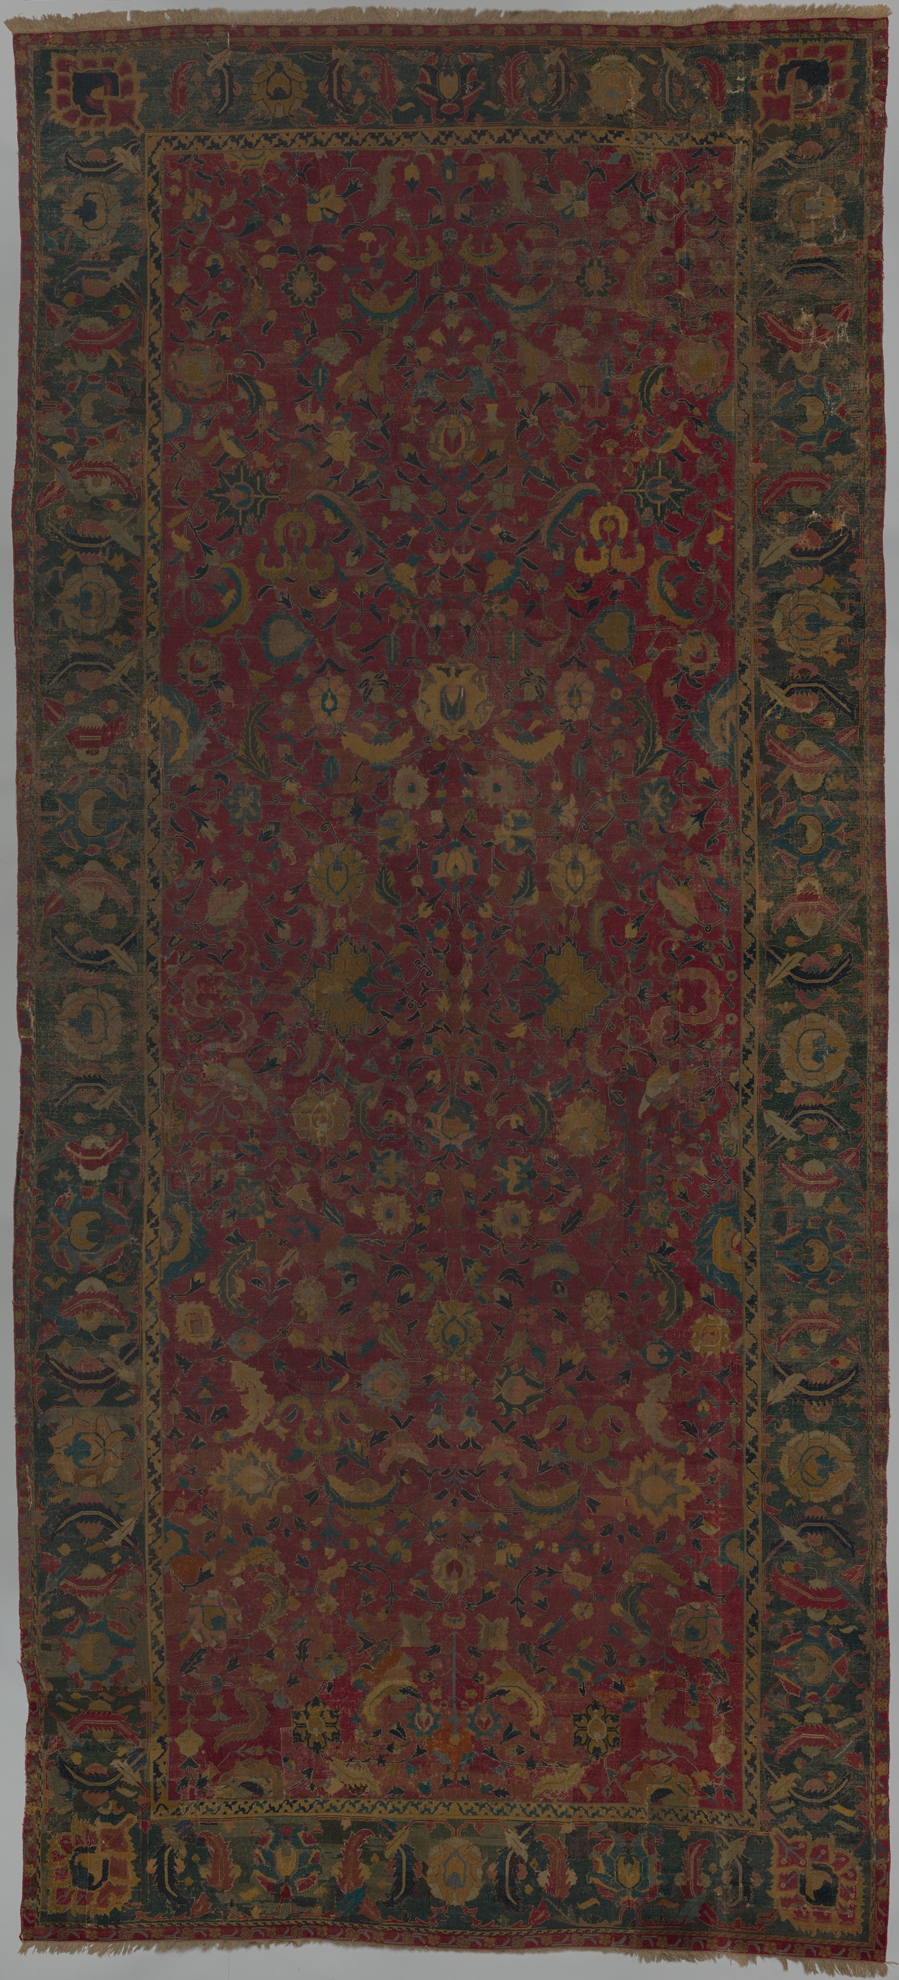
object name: carpet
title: Indo-Persian carpet with vine scroll and palmette pattern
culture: indo-persian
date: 1651-1700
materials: cotton, wool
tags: vines